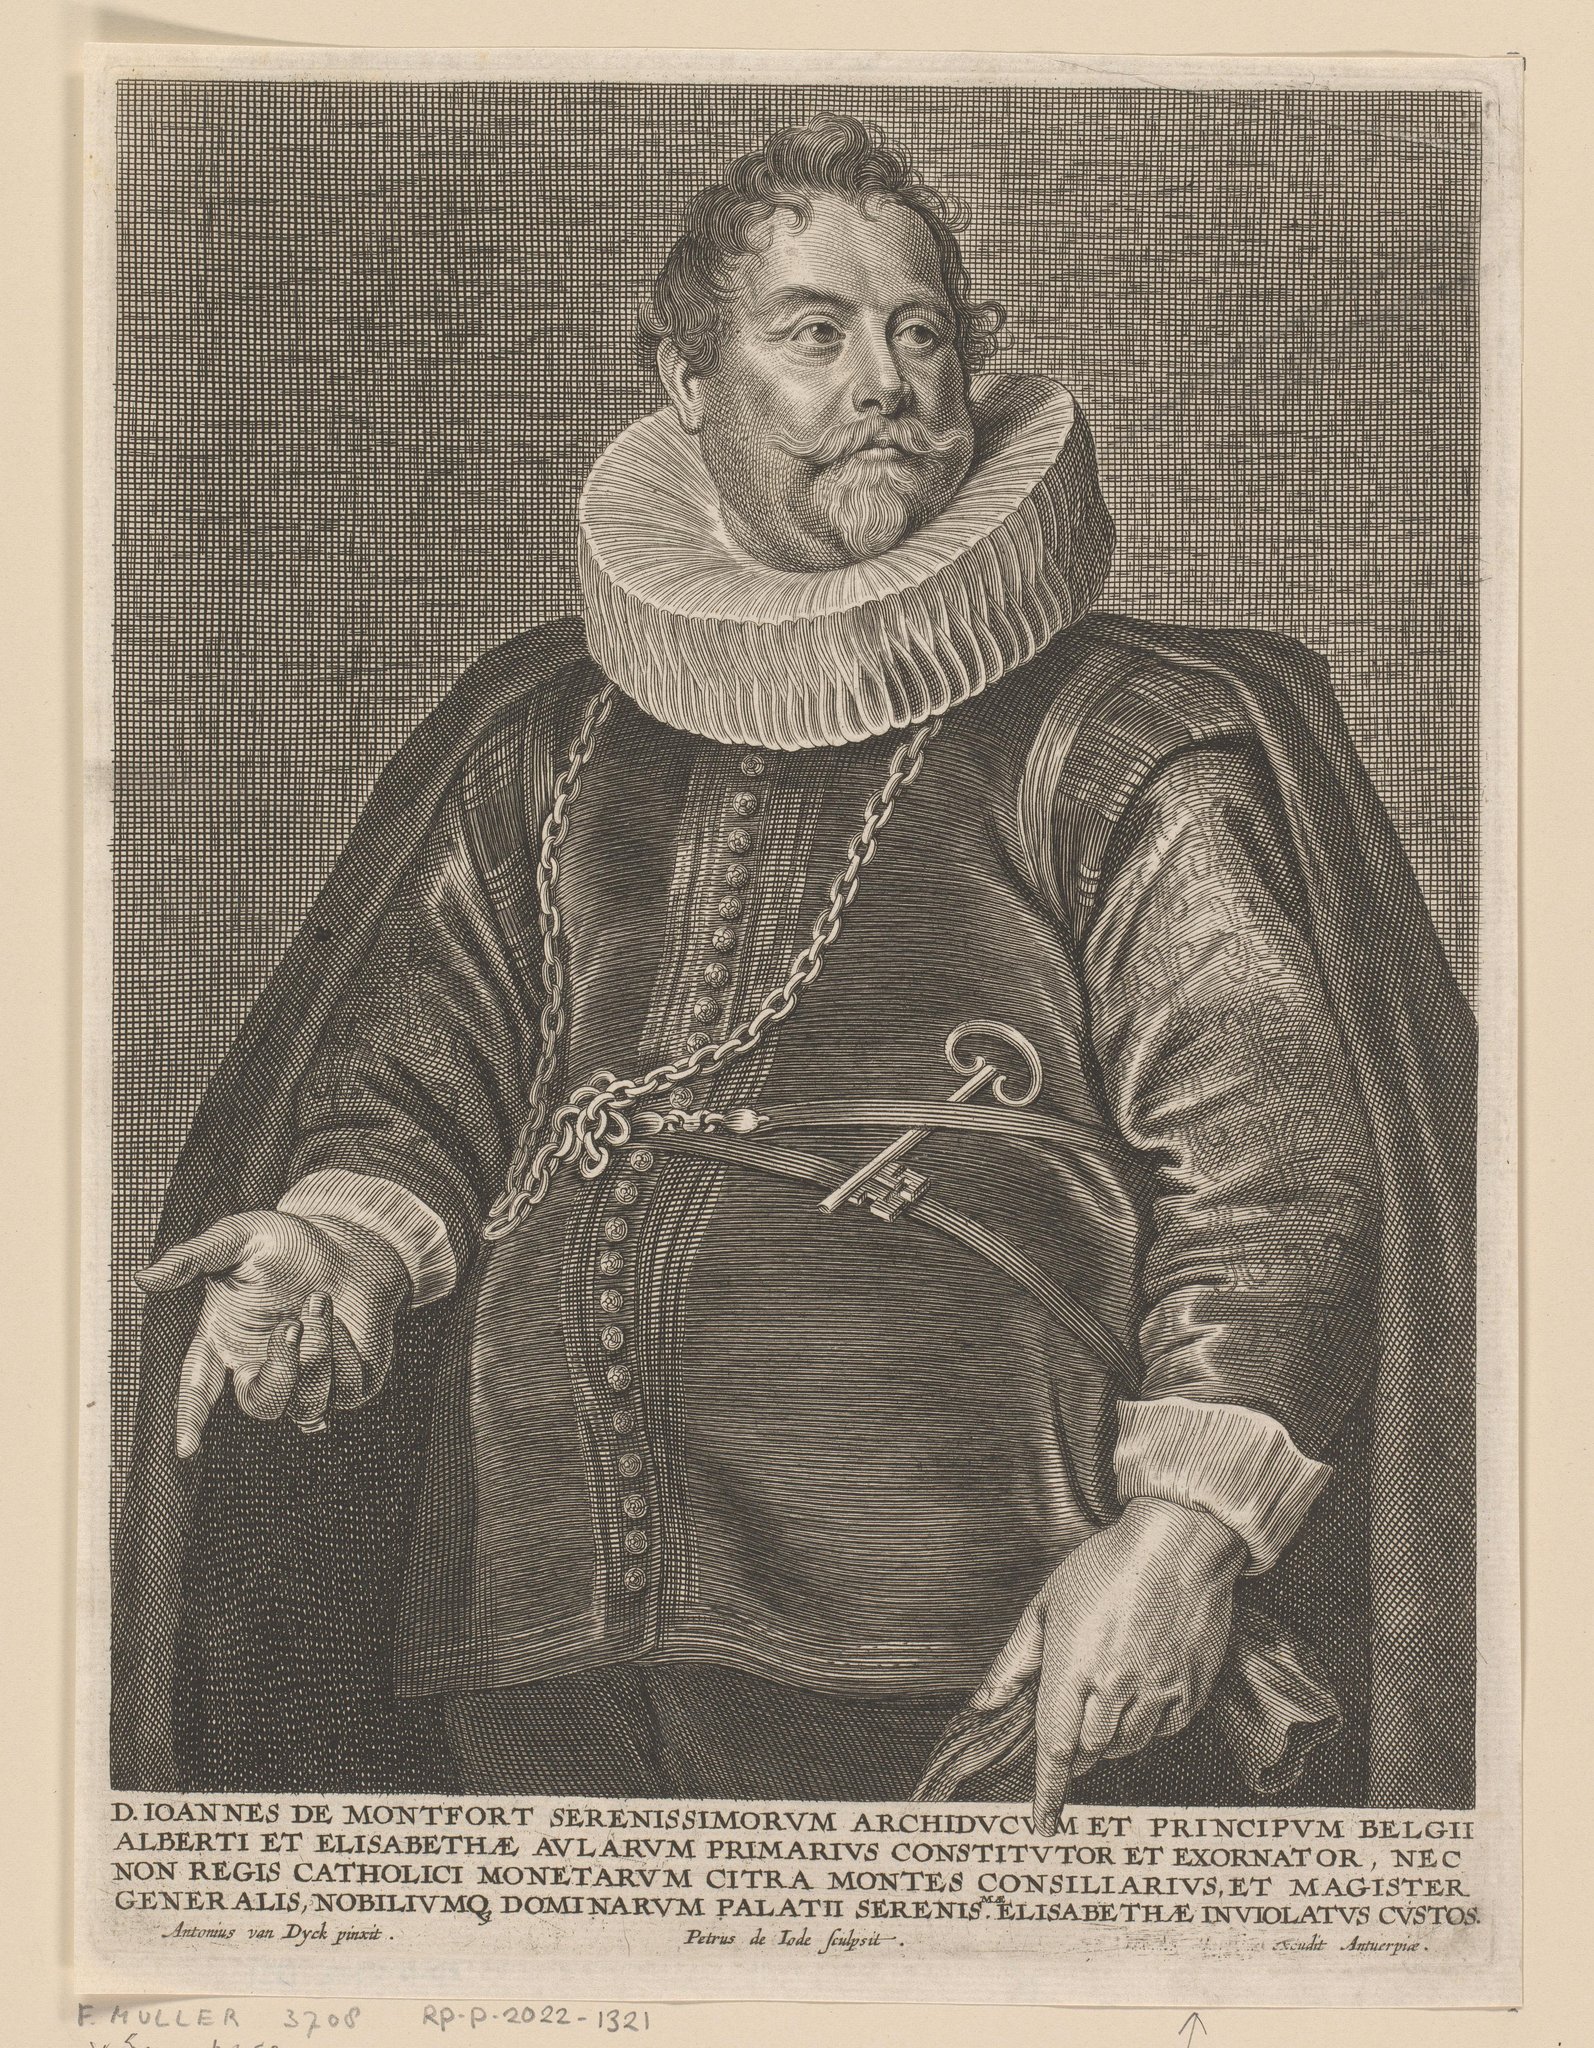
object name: print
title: Portret van Jan van Montfort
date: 1628-1670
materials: paper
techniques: engraving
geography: antwerp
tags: historical persons, key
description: Met vierregelig onderschrift in het Nederlands.